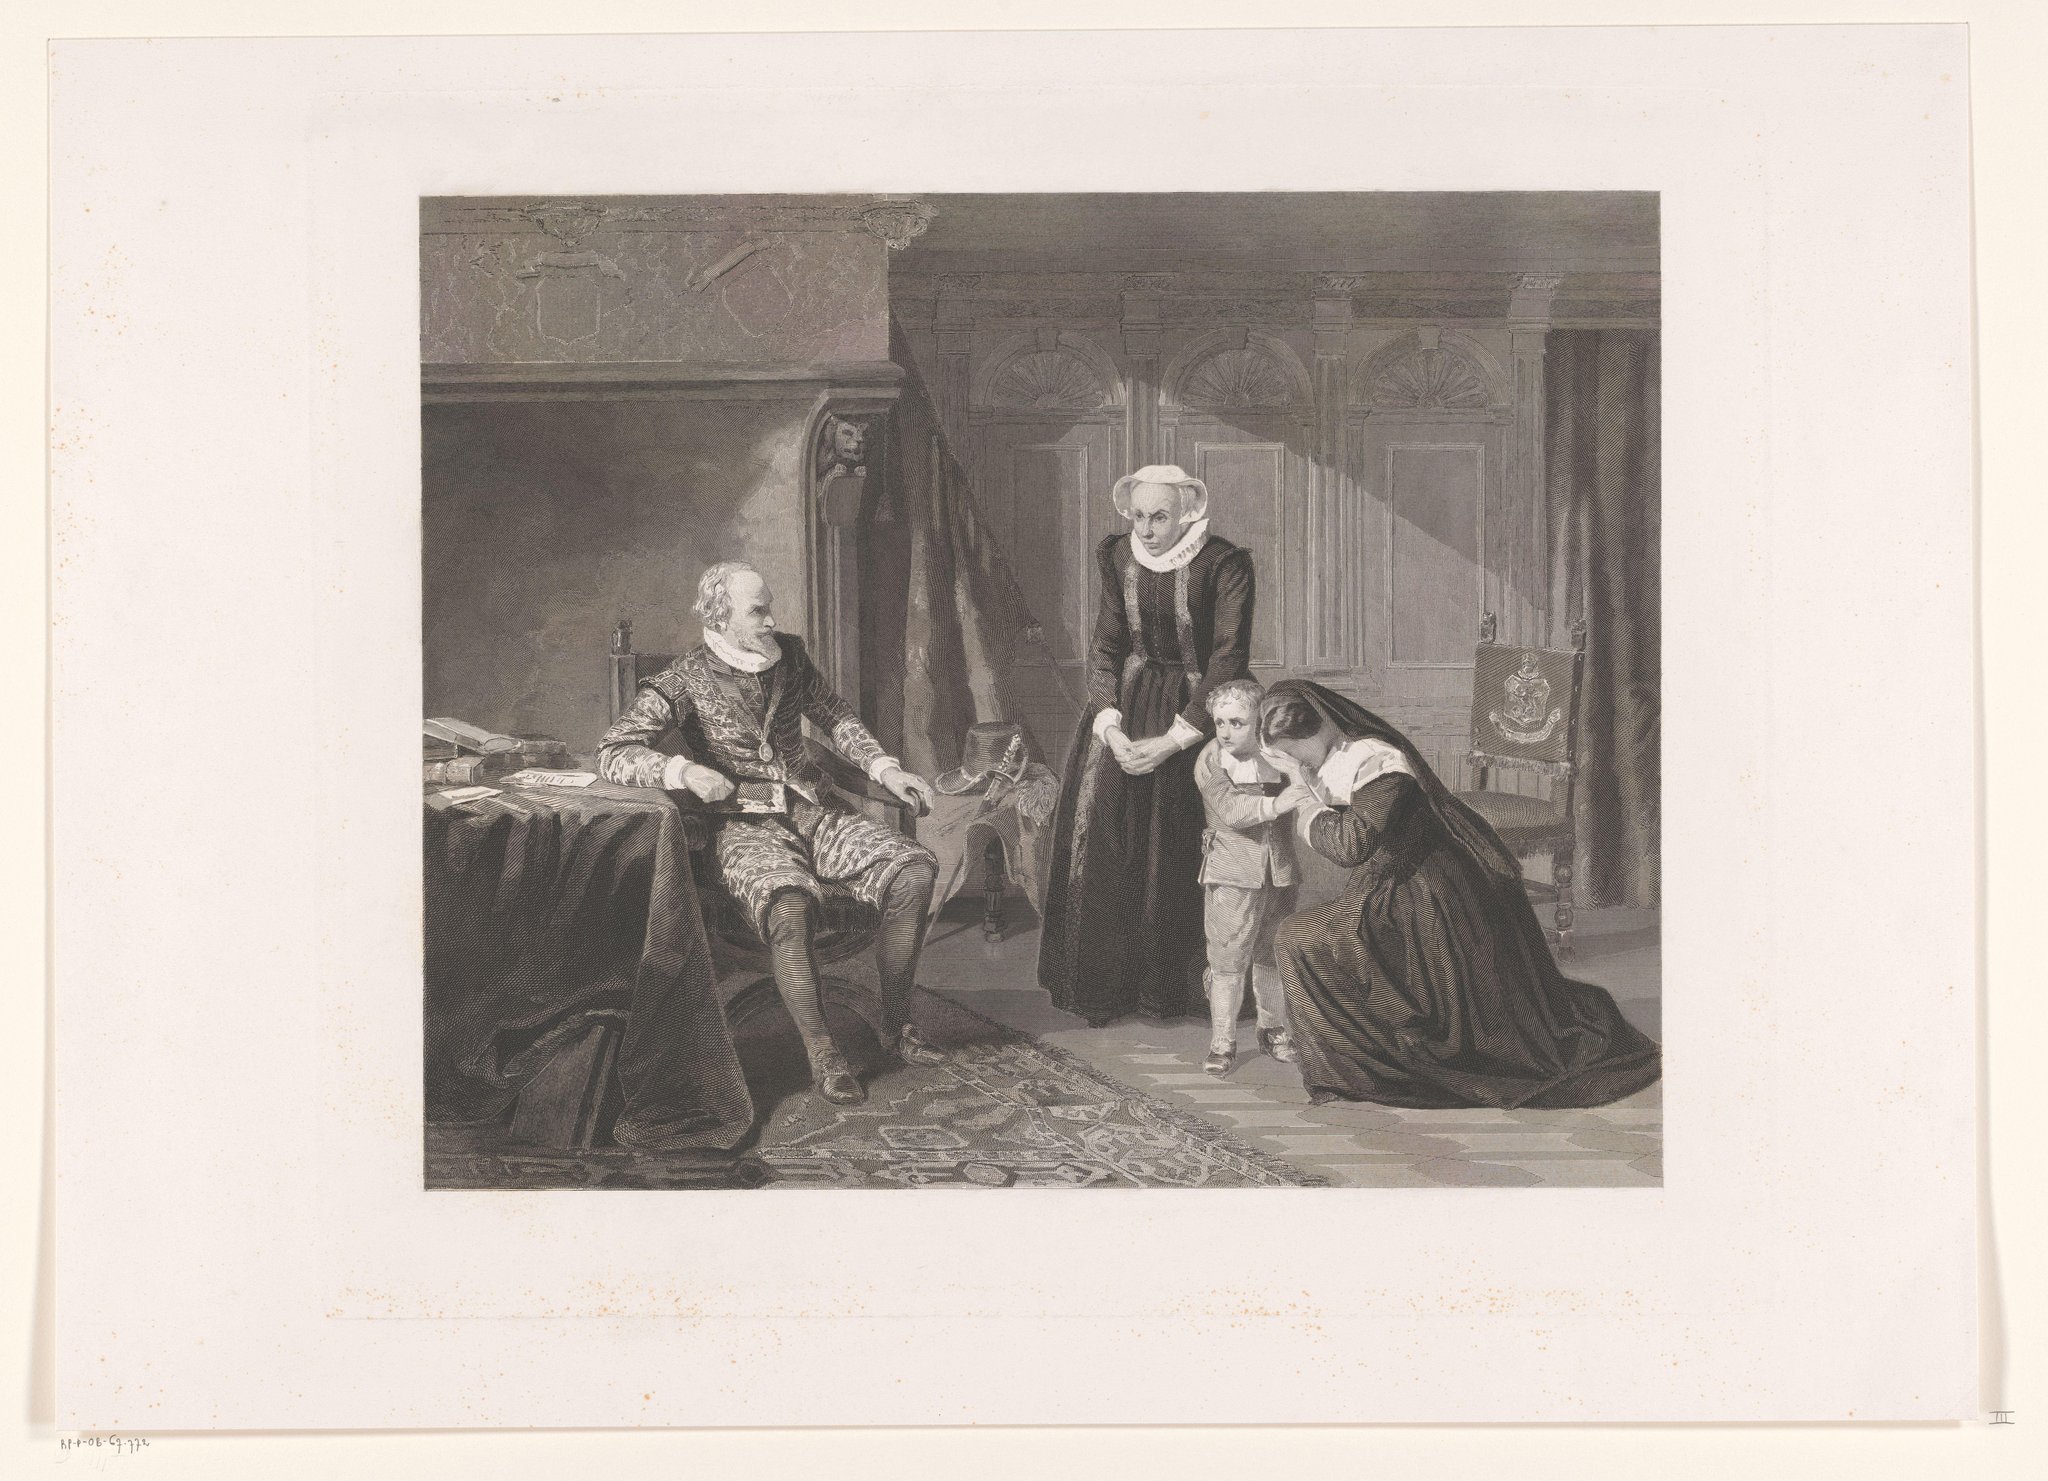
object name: print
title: De moeder, vrouw en zoon van Reinier van Oldenbarnevelt smeken Maurits om genade, 1623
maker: johann wilhelm kaiser (i)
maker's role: draughtsman, print maker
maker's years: 1813-1900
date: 1850-1899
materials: paper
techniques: roulette, engraving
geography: netherlands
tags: the hague, maurice (prince of orange)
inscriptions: collector's mark: Lugt 2228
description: De moeder, vrouw en zoon van Reinier van Oldenbarnevelt zitten bij prins Maurits aan een tafel en smeken om genade voor Reinier van Oldenbarnevelt, één van de ter dood veroordeelde samenzweerders, maart 1623.